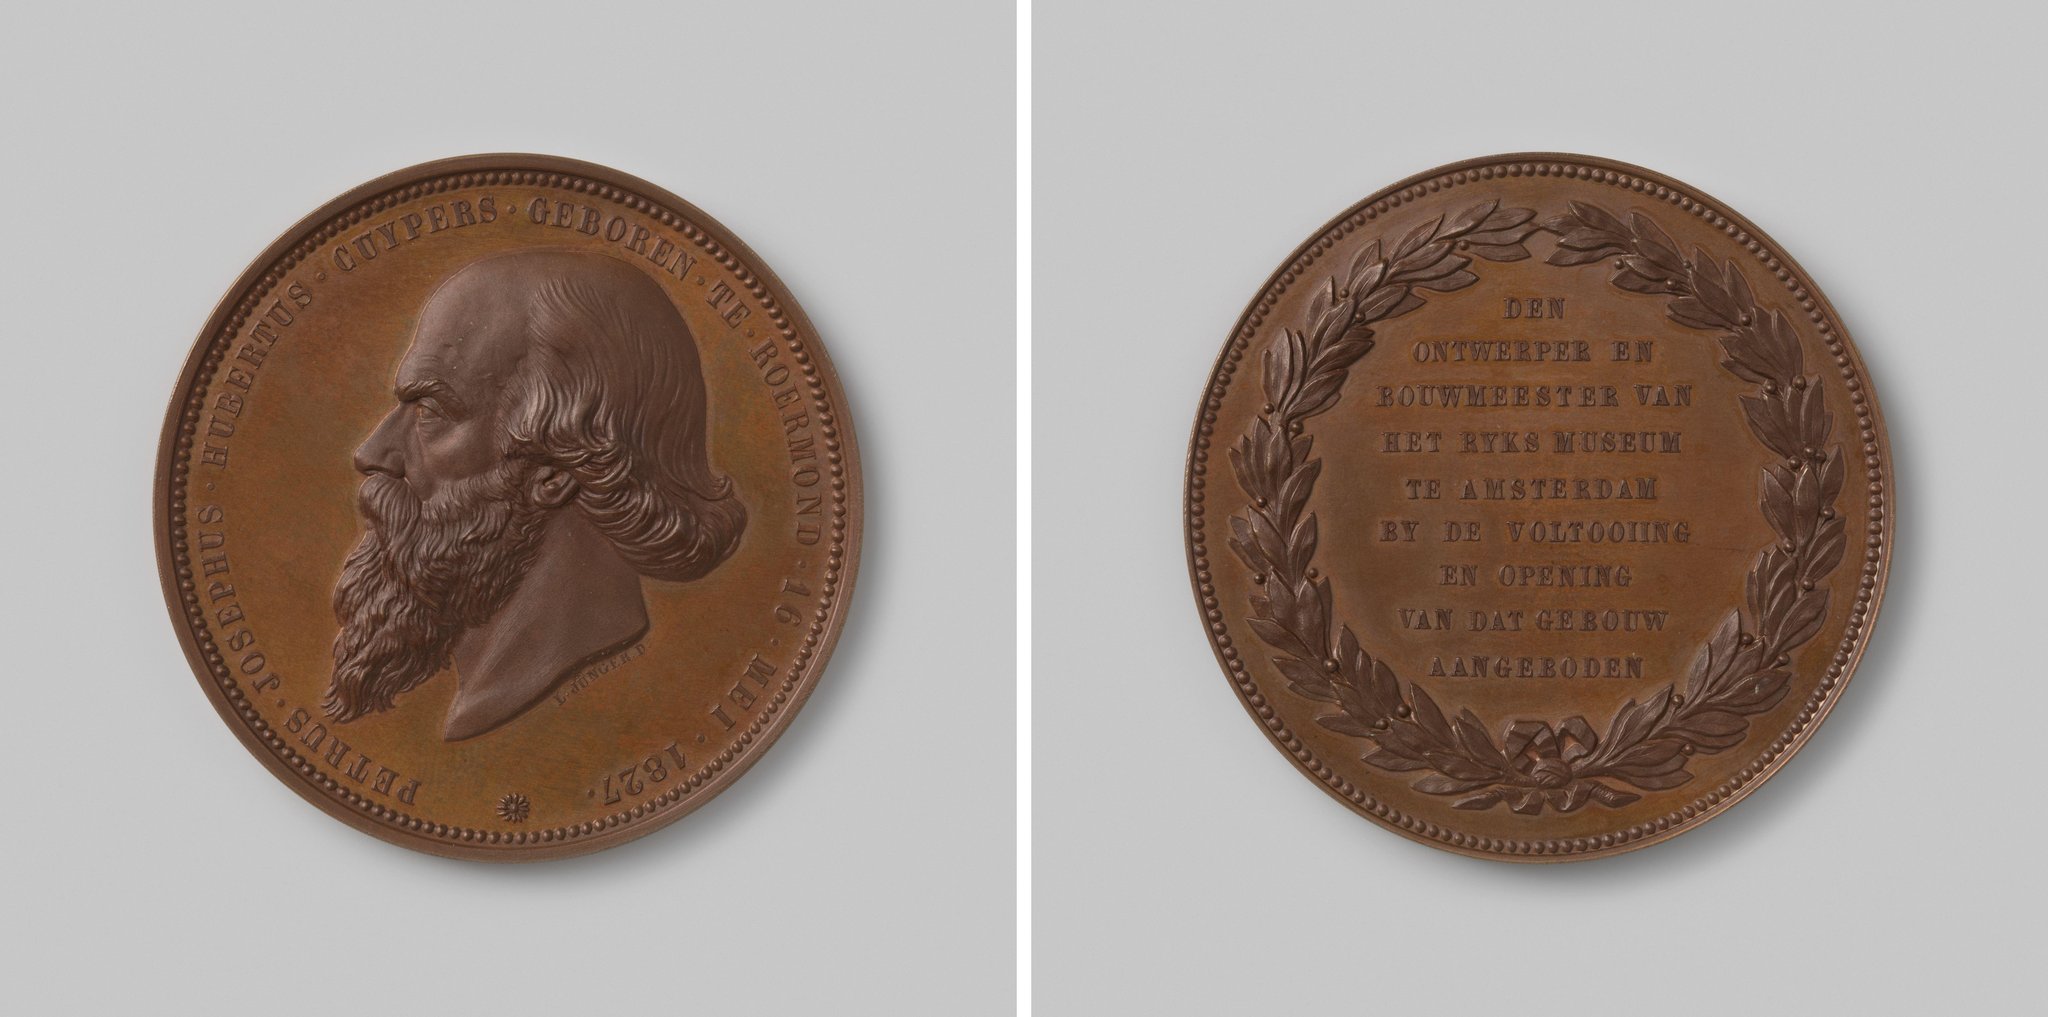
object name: honorary medal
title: P.J.H. Cuypers, penning aangeboden bij de opening van het Rijksmuseum te Amsterdam in cassette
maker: ludwig jünger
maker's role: medailleur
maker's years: 1857-1908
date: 1885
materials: bronze, cardboard, leather, linen, velvet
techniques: striking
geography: utrecht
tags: draughtsman, pierre joseph hubert cuypers, rijksmuseum amsterdam, amsterdam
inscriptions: circumscription: ‘PETRUS . JOSEPHUS . HUBERTUS . CUYPERS . GEBOREN . TE . ROERMOND . 16 . MEI . 1827’, inscription: ‘DEN / ONTWERPER EN / BOUWMEESTER VAN / HET RYKS MUSEUM / TE AMSTERDAM / BY DE VOLTOOIING / EN OPENING / VAN DAT GEBOUW / AANGEBODEN’, signature: ‘L. JÜNGER . D .’, inscription: ‘J.P.M.F.’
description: Bronzen penning. Voorzijde: naar links gekeerd profiel van Cuypers in reliëf binnen omschrift. Keerzijde: opschrift binnen lauwerkrans. Geheel in cassette: binnenzijde paars fluweel, buitenzijde bruin leer met verguld randje omplakt. Met bijbehorende doos NG-2000-1-2.